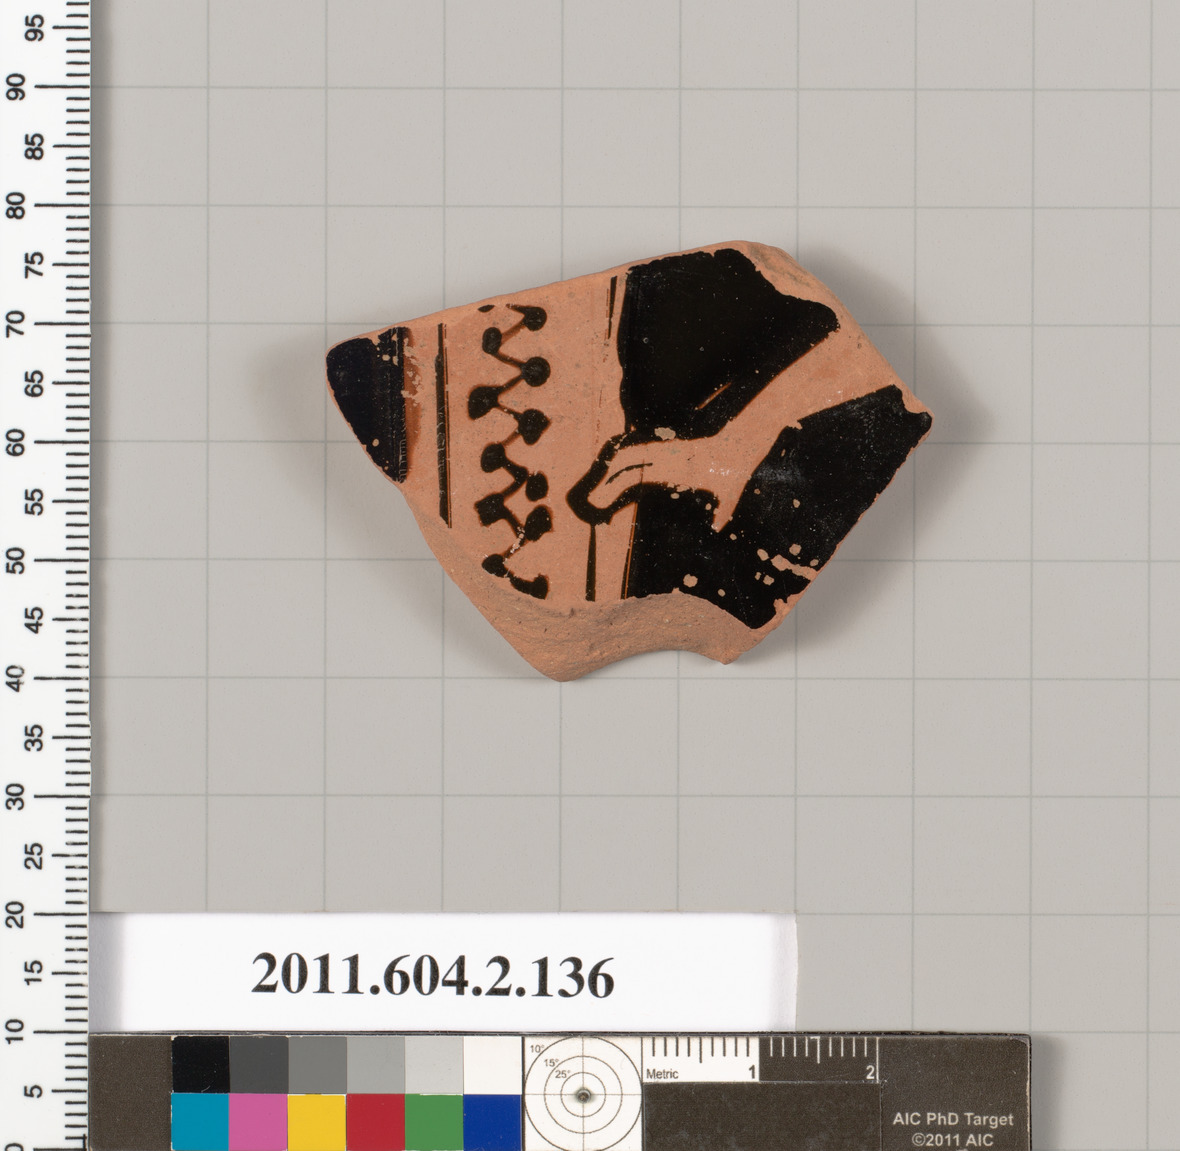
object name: pelike fragment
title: Terracotta fragment of a pelike (jar)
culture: greek, attic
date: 425-400 BCE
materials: terracotta